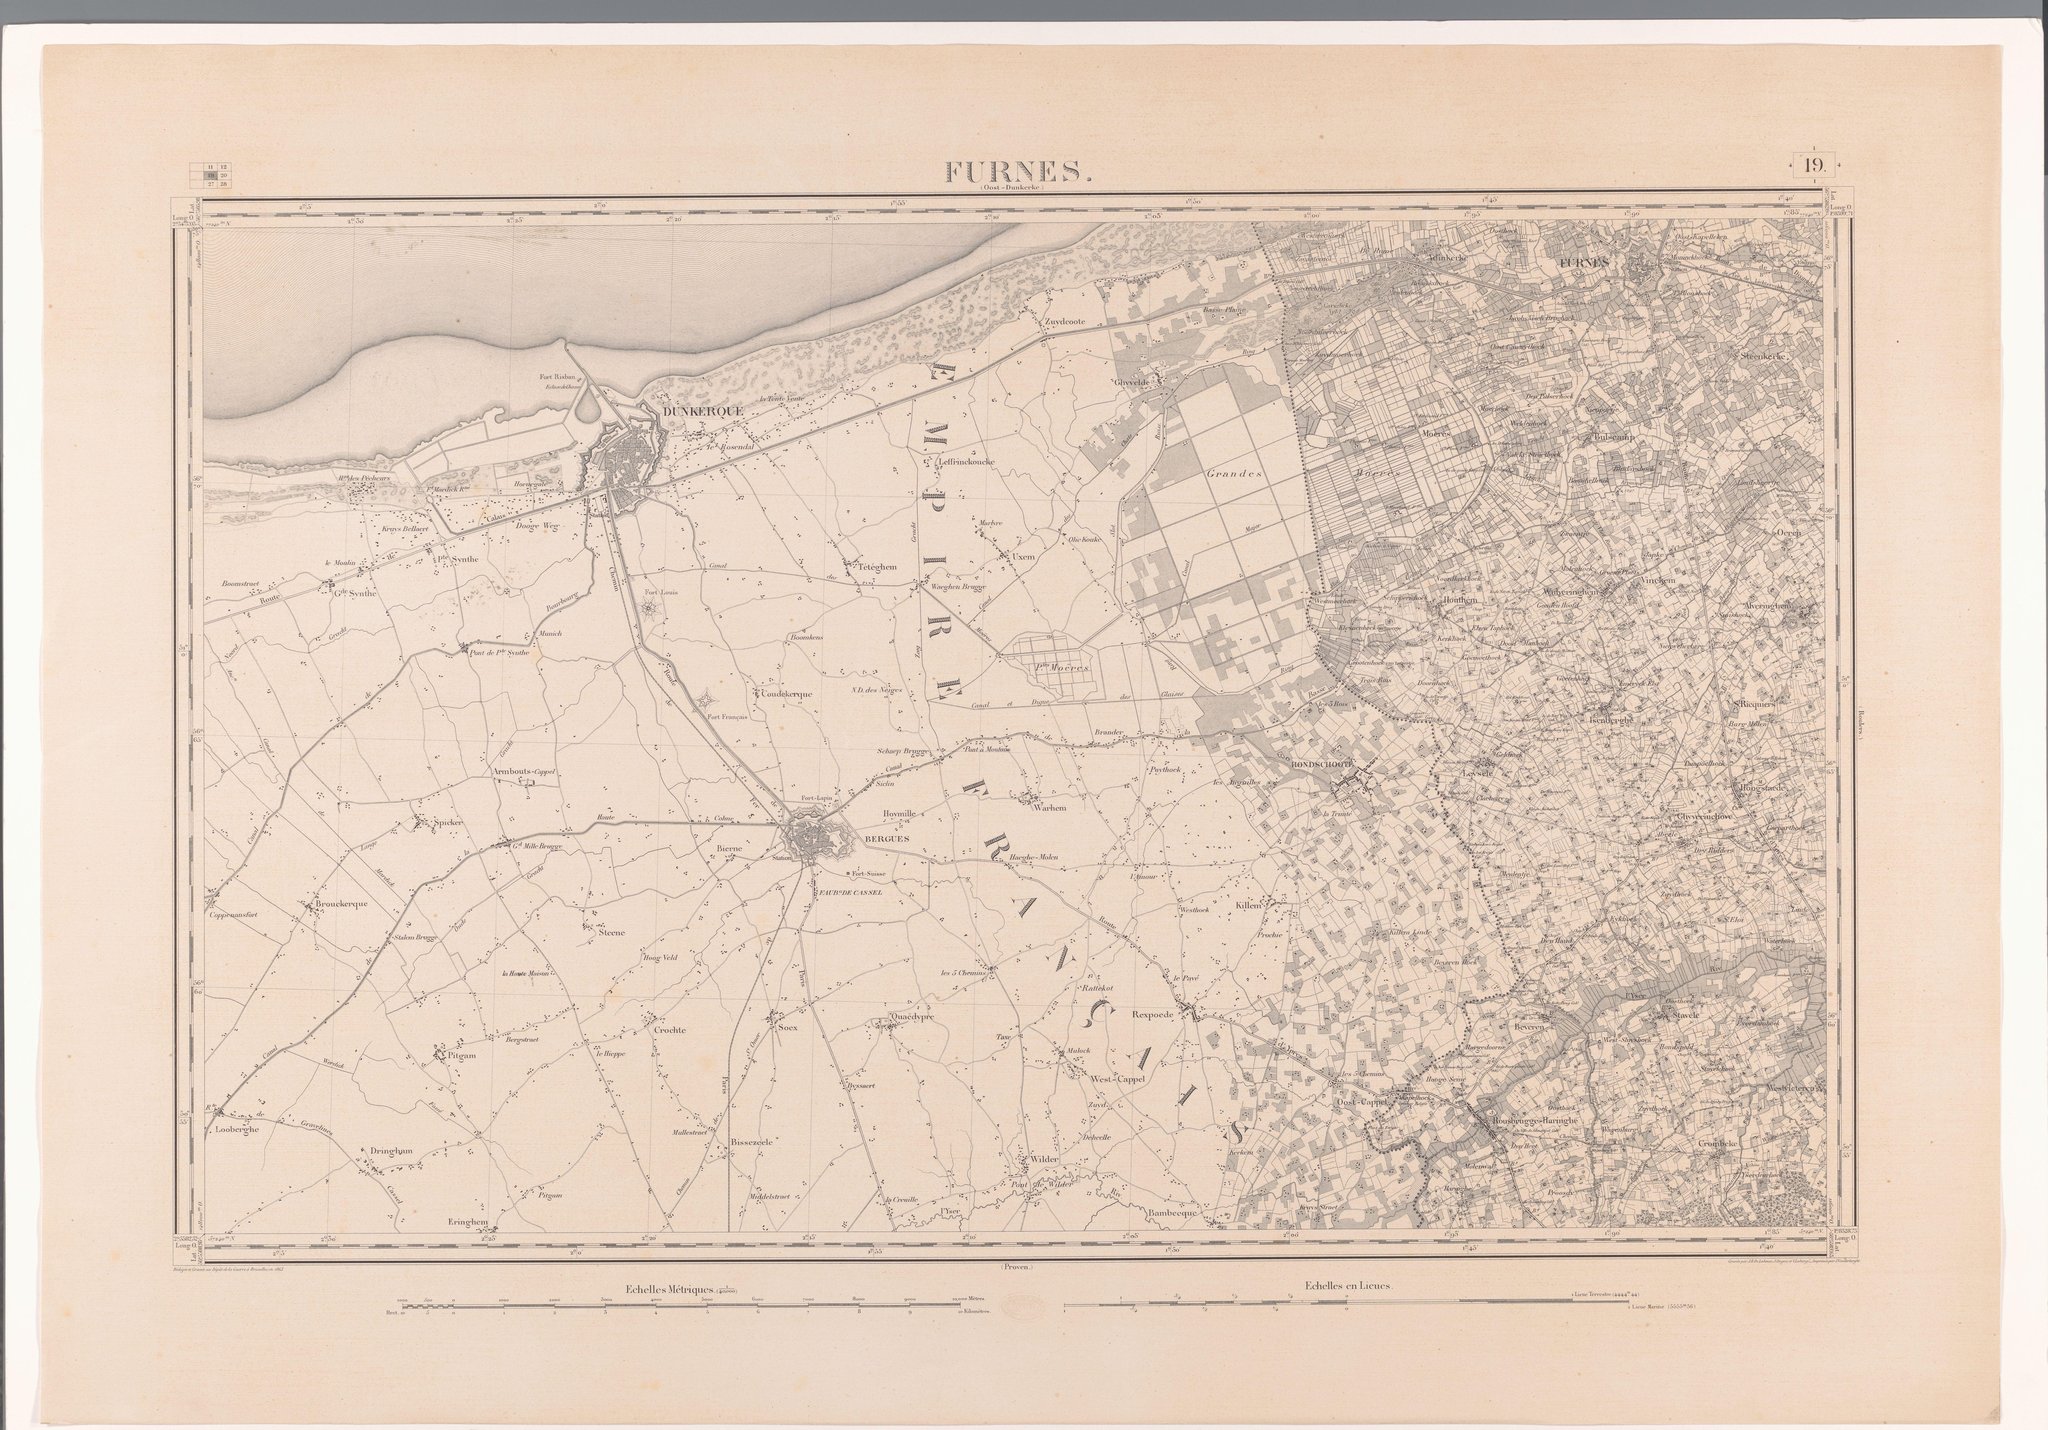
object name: map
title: Furnes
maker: j. vanderborght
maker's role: printer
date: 1863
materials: paper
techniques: lithograph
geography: brussels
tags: maps of separate countries or regions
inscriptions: check stamp: ‘Depot de la Guerre Belgique’